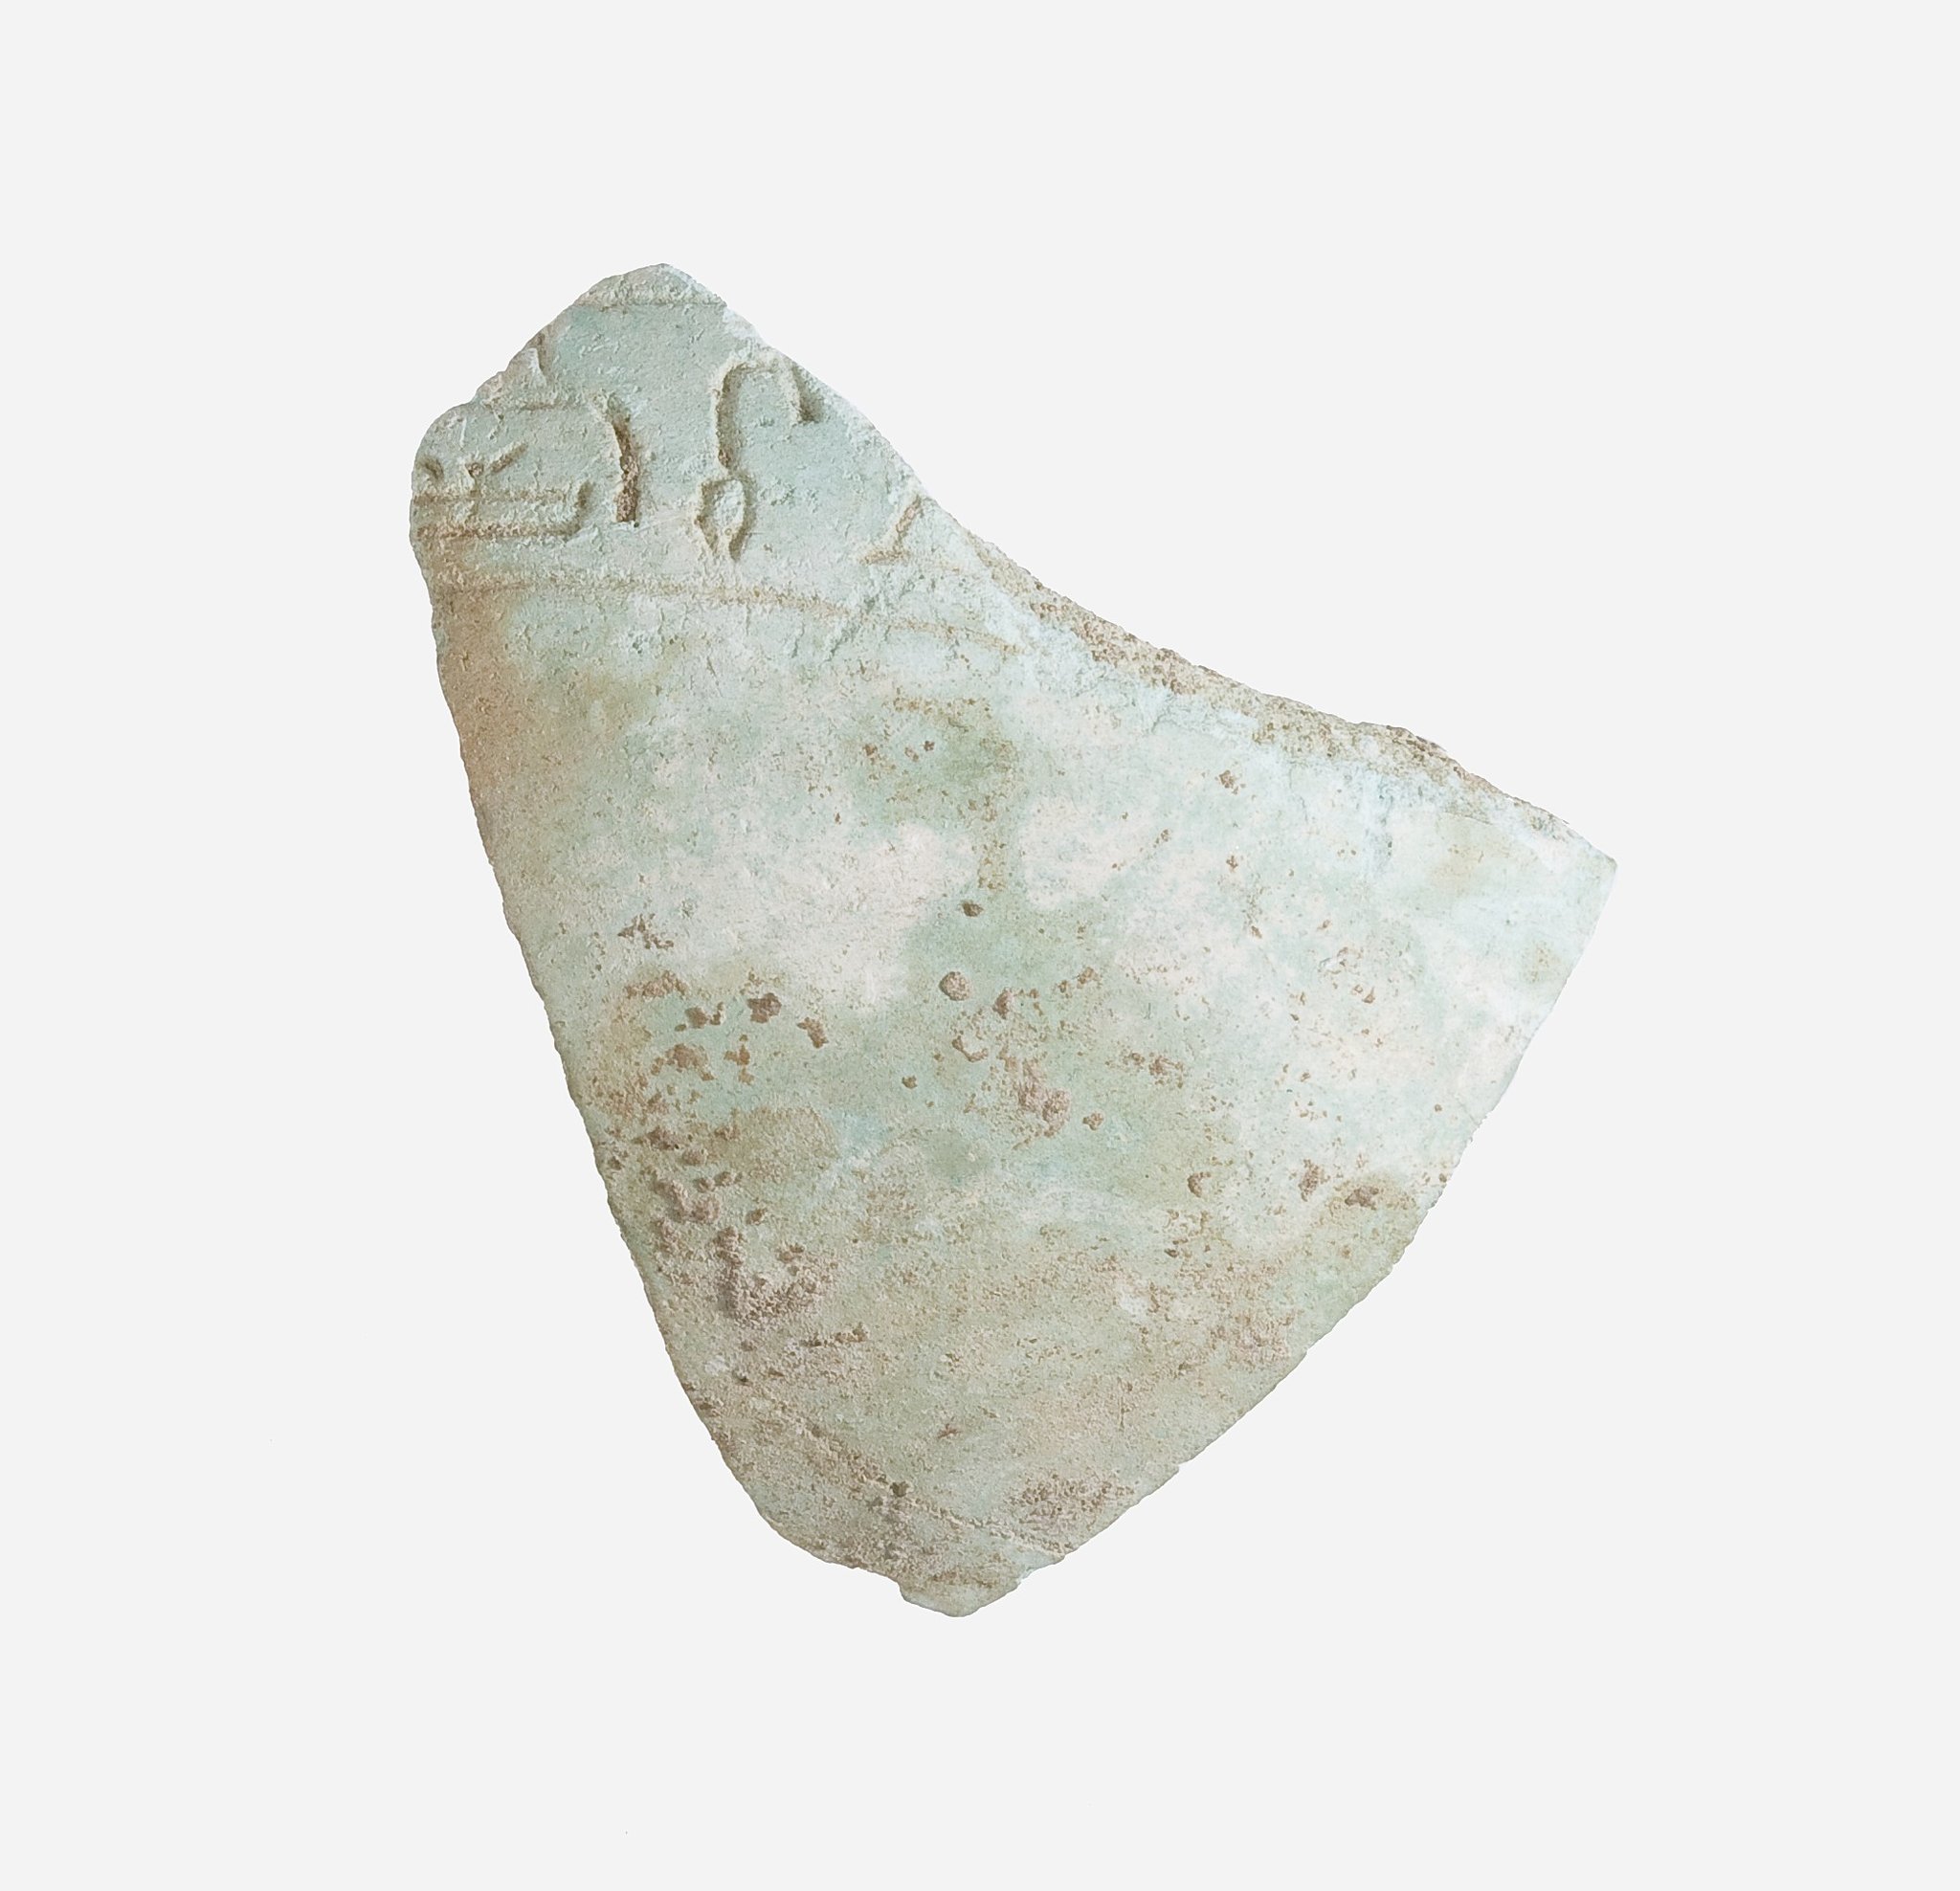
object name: vase fragment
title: Fragment of Vase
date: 1390-1352 BCE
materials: faience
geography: egypt